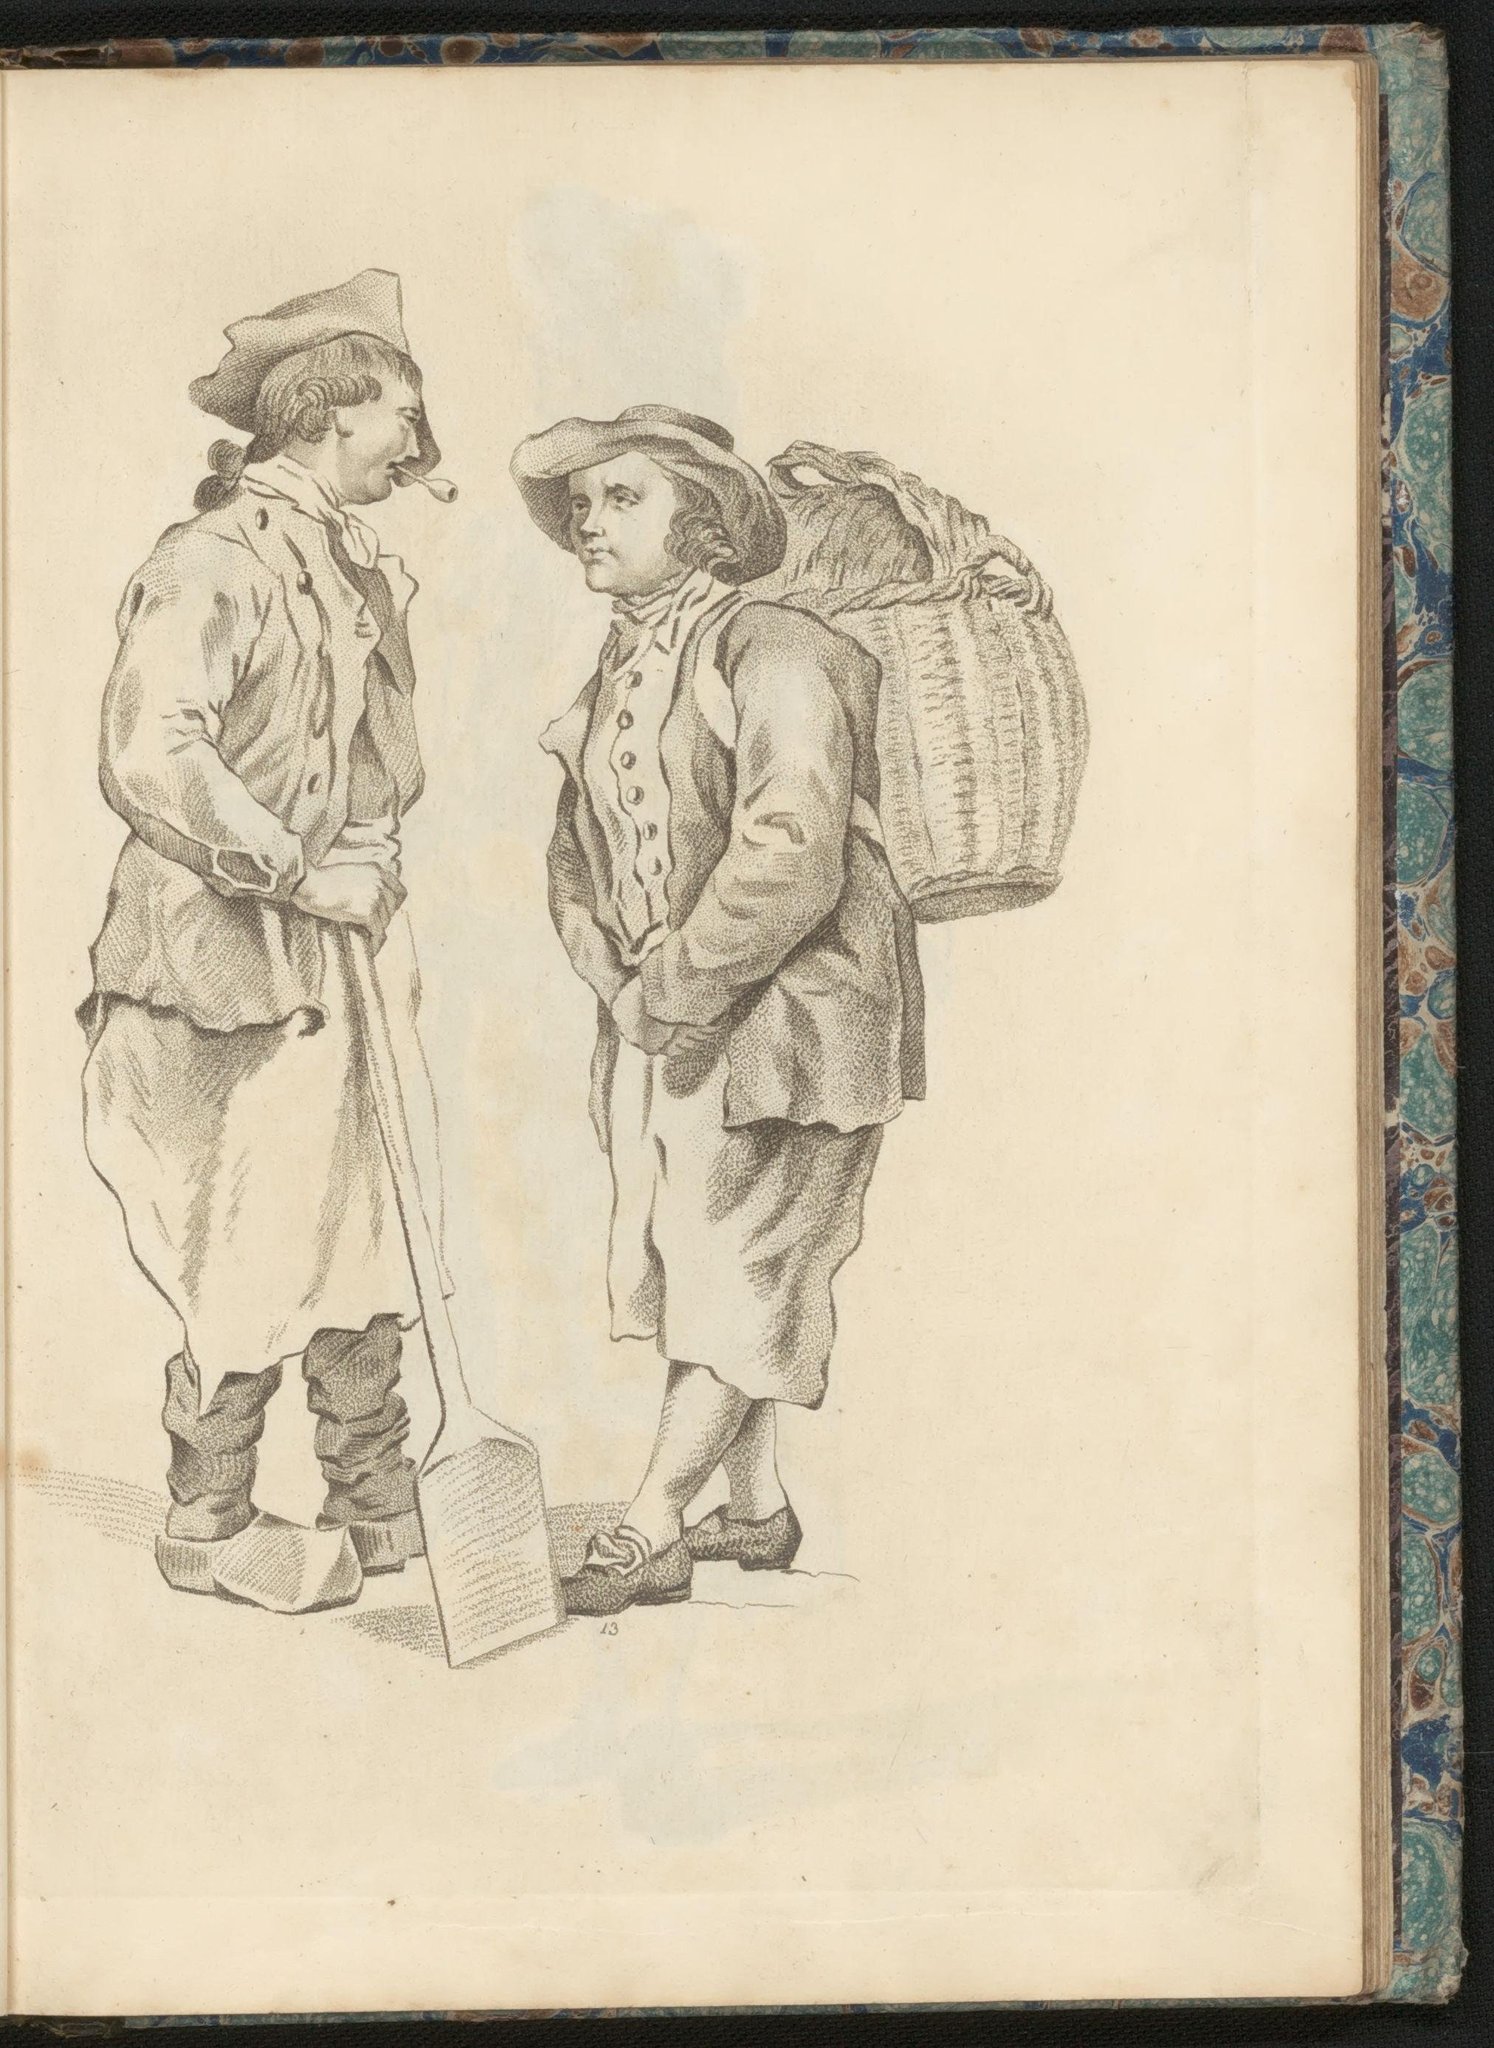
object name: print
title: Twee boeren in gesprek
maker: mathias de sallieth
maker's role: print maker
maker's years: 1749-1791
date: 1772-1791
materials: paper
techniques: printmaking, etching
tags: pipe ~ tobacco, farmers, carrying something in basket, bag, rucksack, etc., agricultural implements: spade, folk costume, regional costume, conversation, dialogue; conversation piece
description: De prent verscheen vanaf 1818 tevens als onderdeel van een 33-delige reeks prenten door Mathias de Sallieth, samengebonden in: Perkois, Jacobus, Prins, Johannes Huibert. Verzameling van verschillende gekleede mans- en vrouwenstanden, ter oefening van jonge schilders en liefhebbers. Rotterdam: Johannes Immerzeel, 1818. Alle verso-bladen uit dit prentalbum zijn blanco.